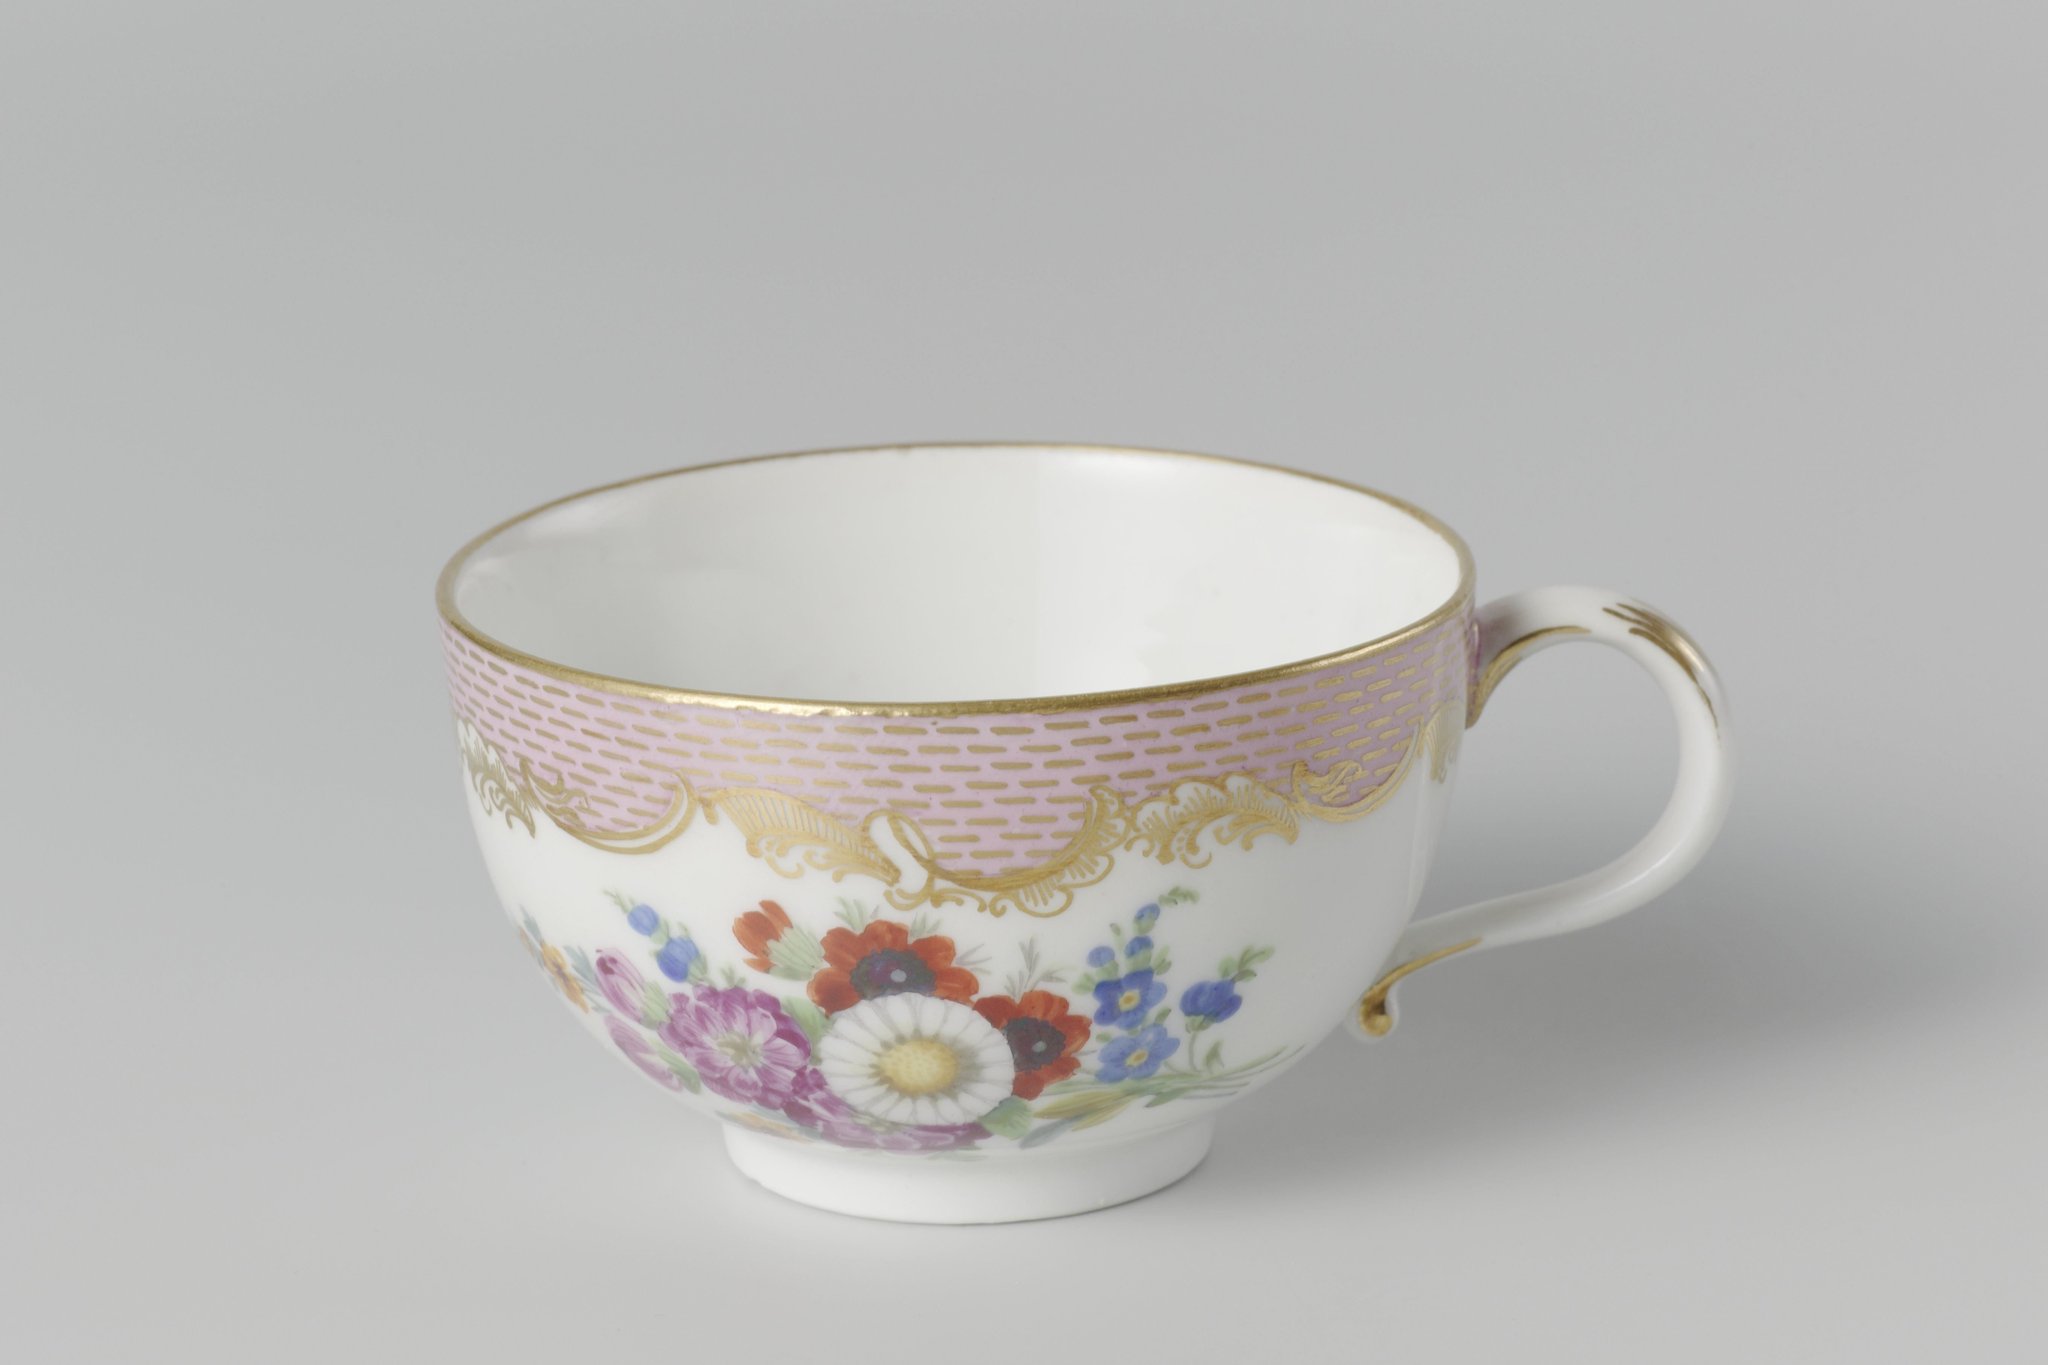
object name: eating drinking utensil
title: Kop, veelkleurig beschilderd met bloemboeketten.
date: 1800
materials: porcelain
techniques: painted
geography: meissen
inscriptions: mark: ‘3’, factory mark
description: Lage kop met oor, van beschilderd porselein. De kop is beschilderd met bloemboeketten en langs de rand een brede strook met strepen in goud op een rose fond, steeds afgezet met een rocaille-ornament in goud. De kop is gemerkt.